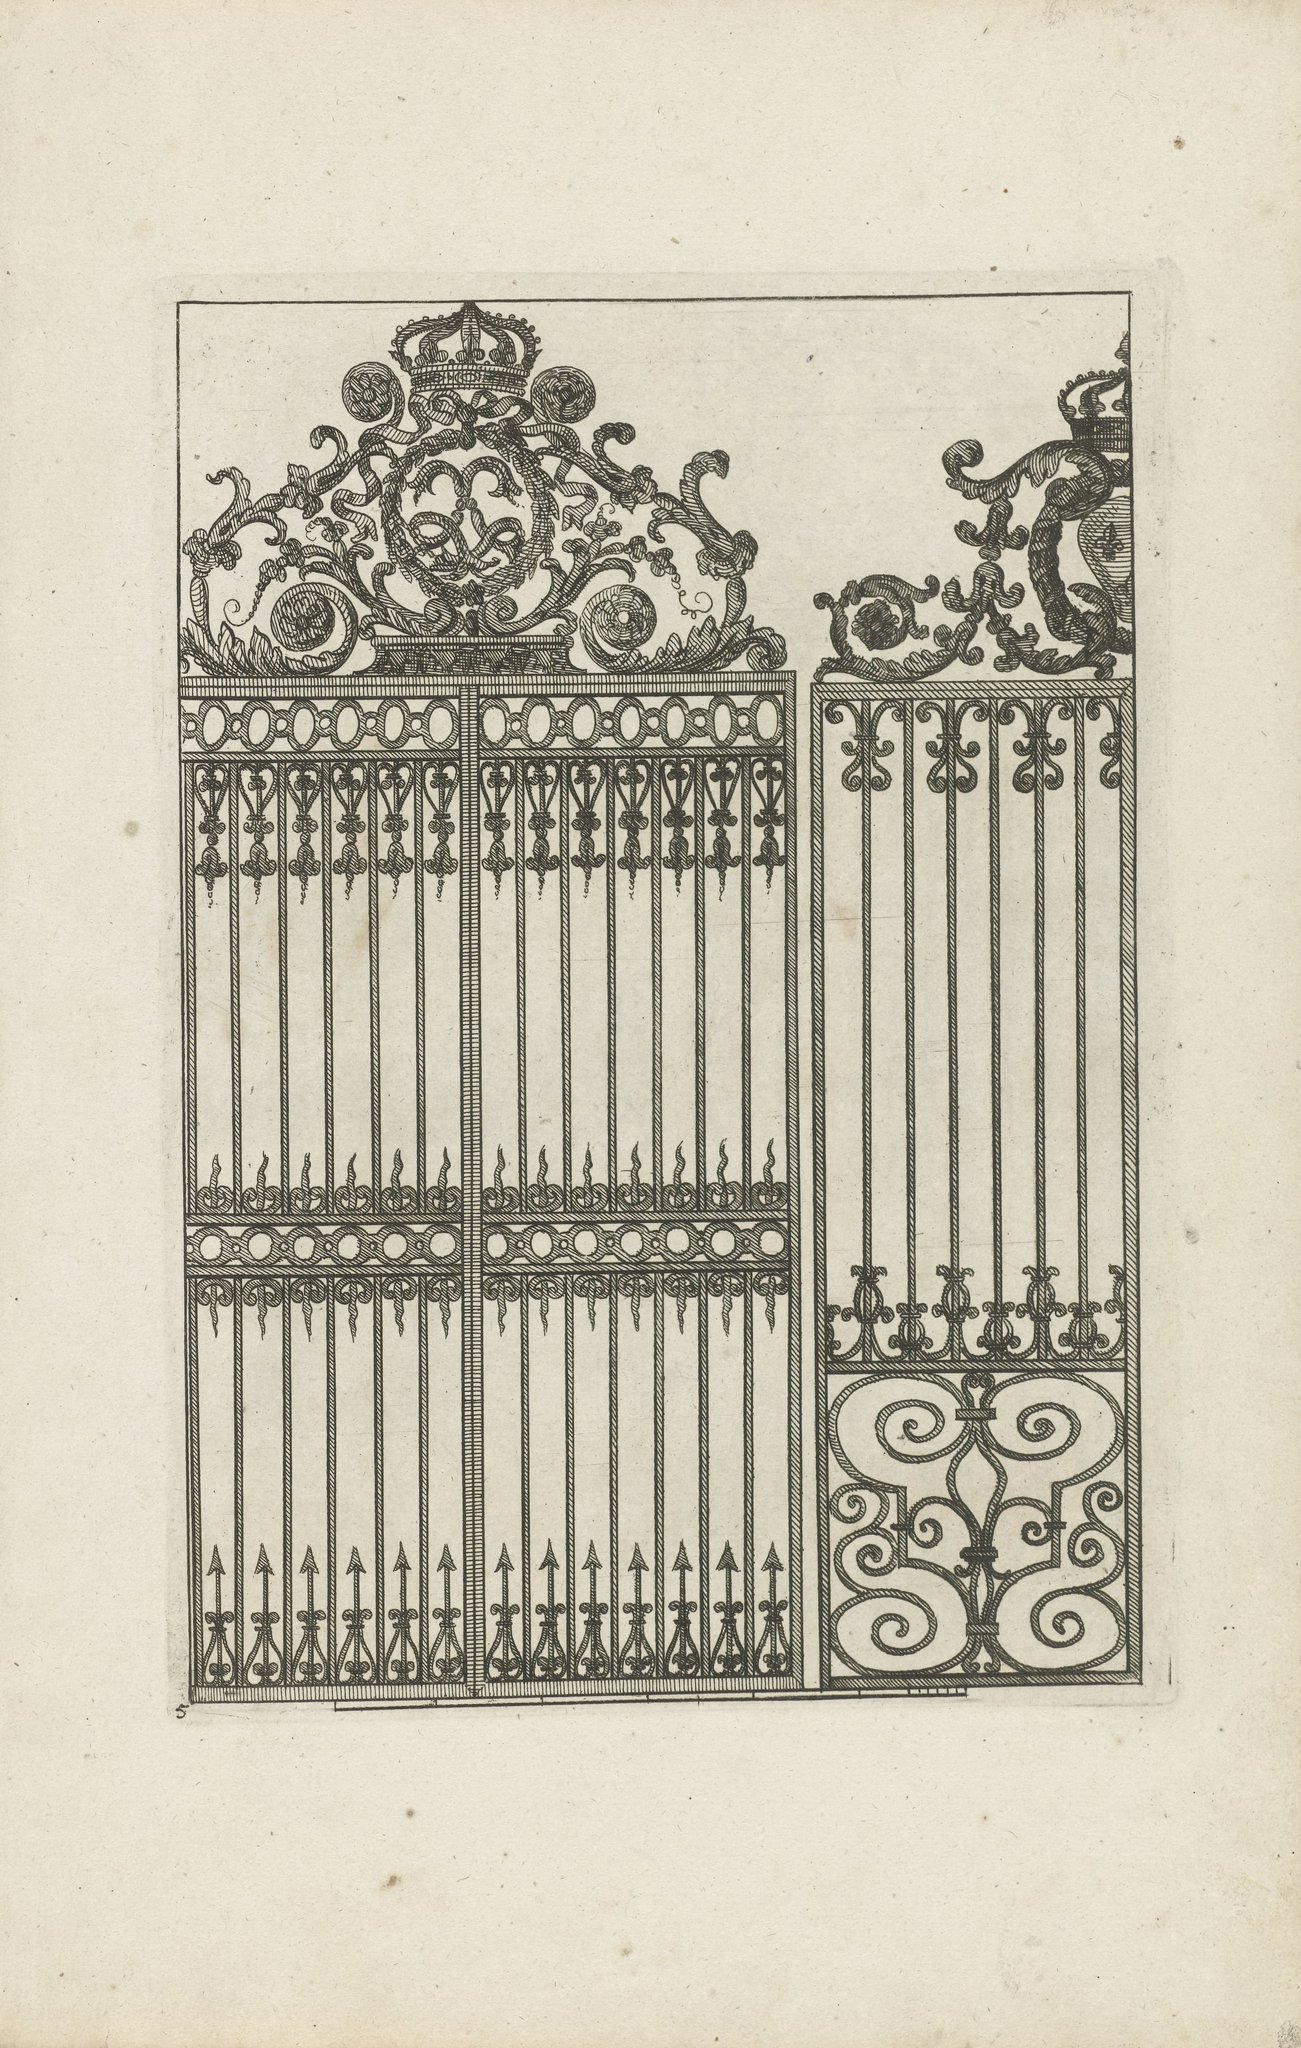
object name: print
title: Smeedwerk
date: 1726-1750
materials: paper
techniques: etching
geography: amsterdam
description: Uit serie van 6 bladen met Nederlandse tegenzijdige kopieën naar bladen uit de serie Liure de Serurerie, ontworpen door Jean Lepautre, en bladen uit een andere serie. Tweede druk.